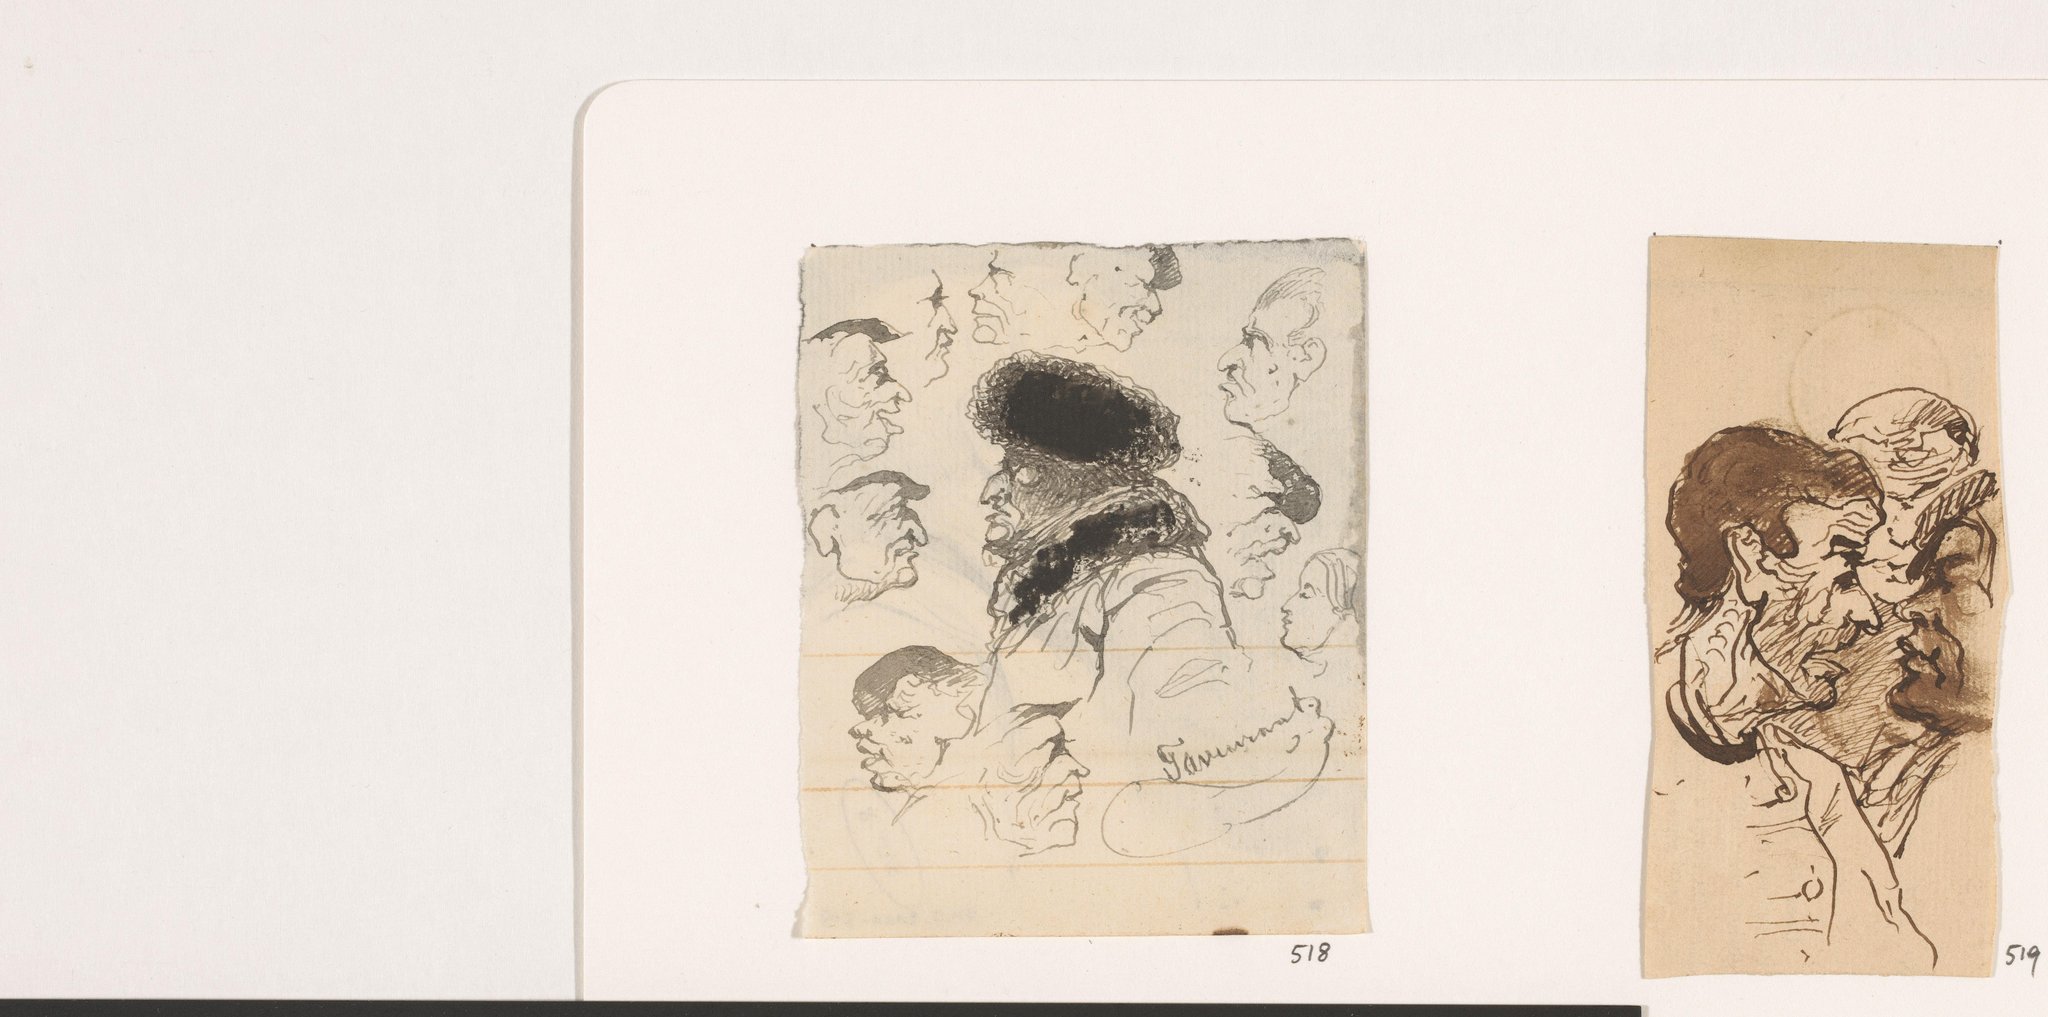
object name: drawing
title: Kop met bontmuts omringd door koppen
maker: johannes tavenraat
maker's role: draughtsman, painter, print maker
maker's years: 1809-1881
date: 1840-1880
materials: ink, paper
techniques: brush, pen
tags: caricatures (human types), head-gear (with name)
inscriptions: signature: ‘Tavenraat’